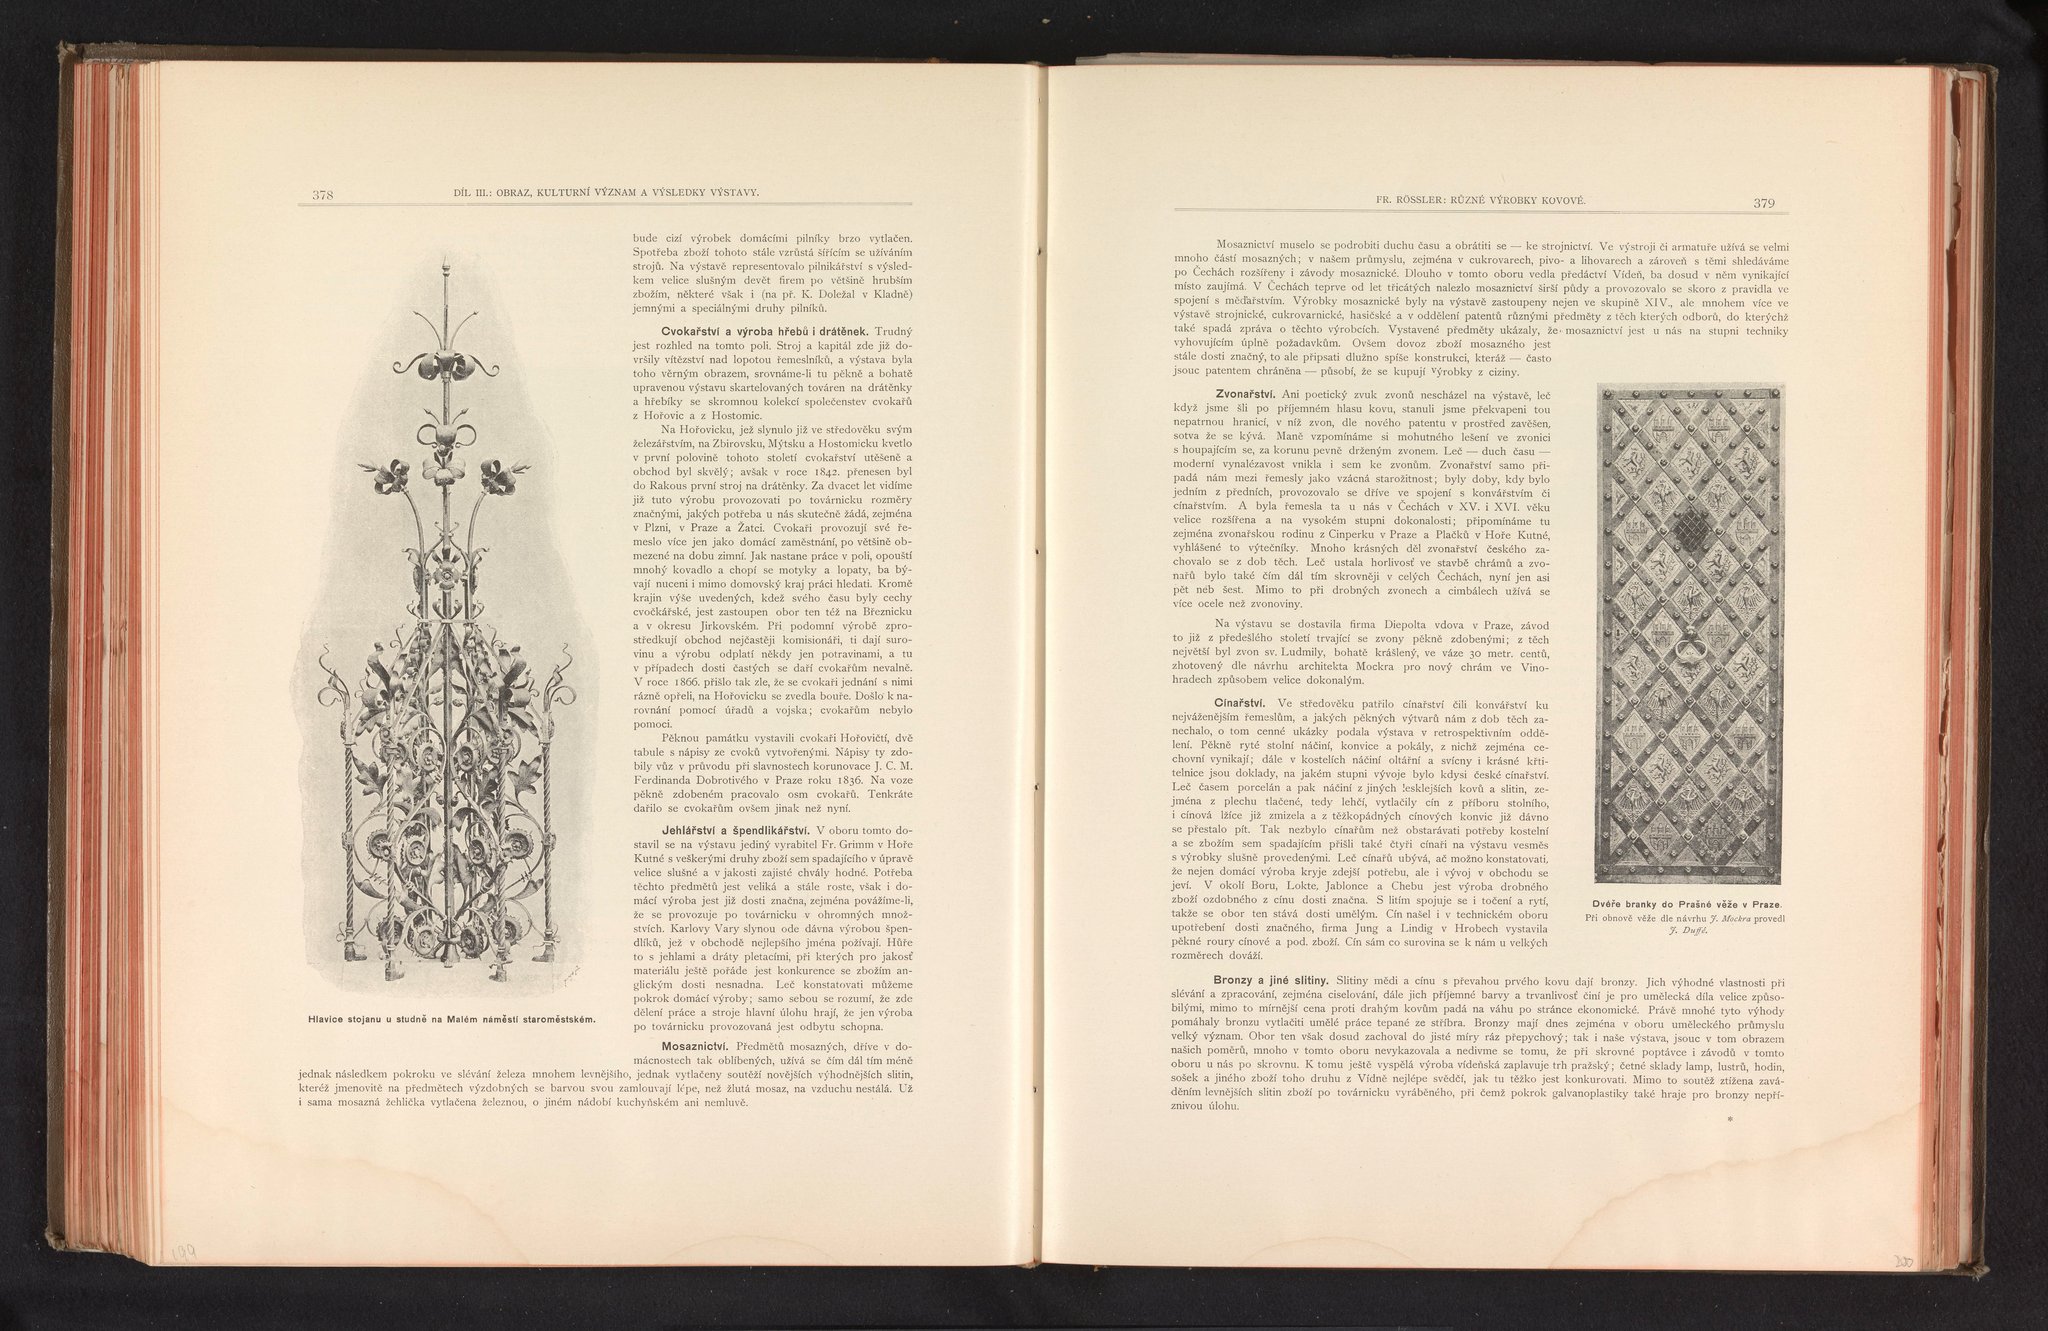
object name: photomechanical print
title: Dvére banky do Prasné veze v Praze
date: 1890-1895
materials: paper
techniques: autotype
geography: prague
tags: door